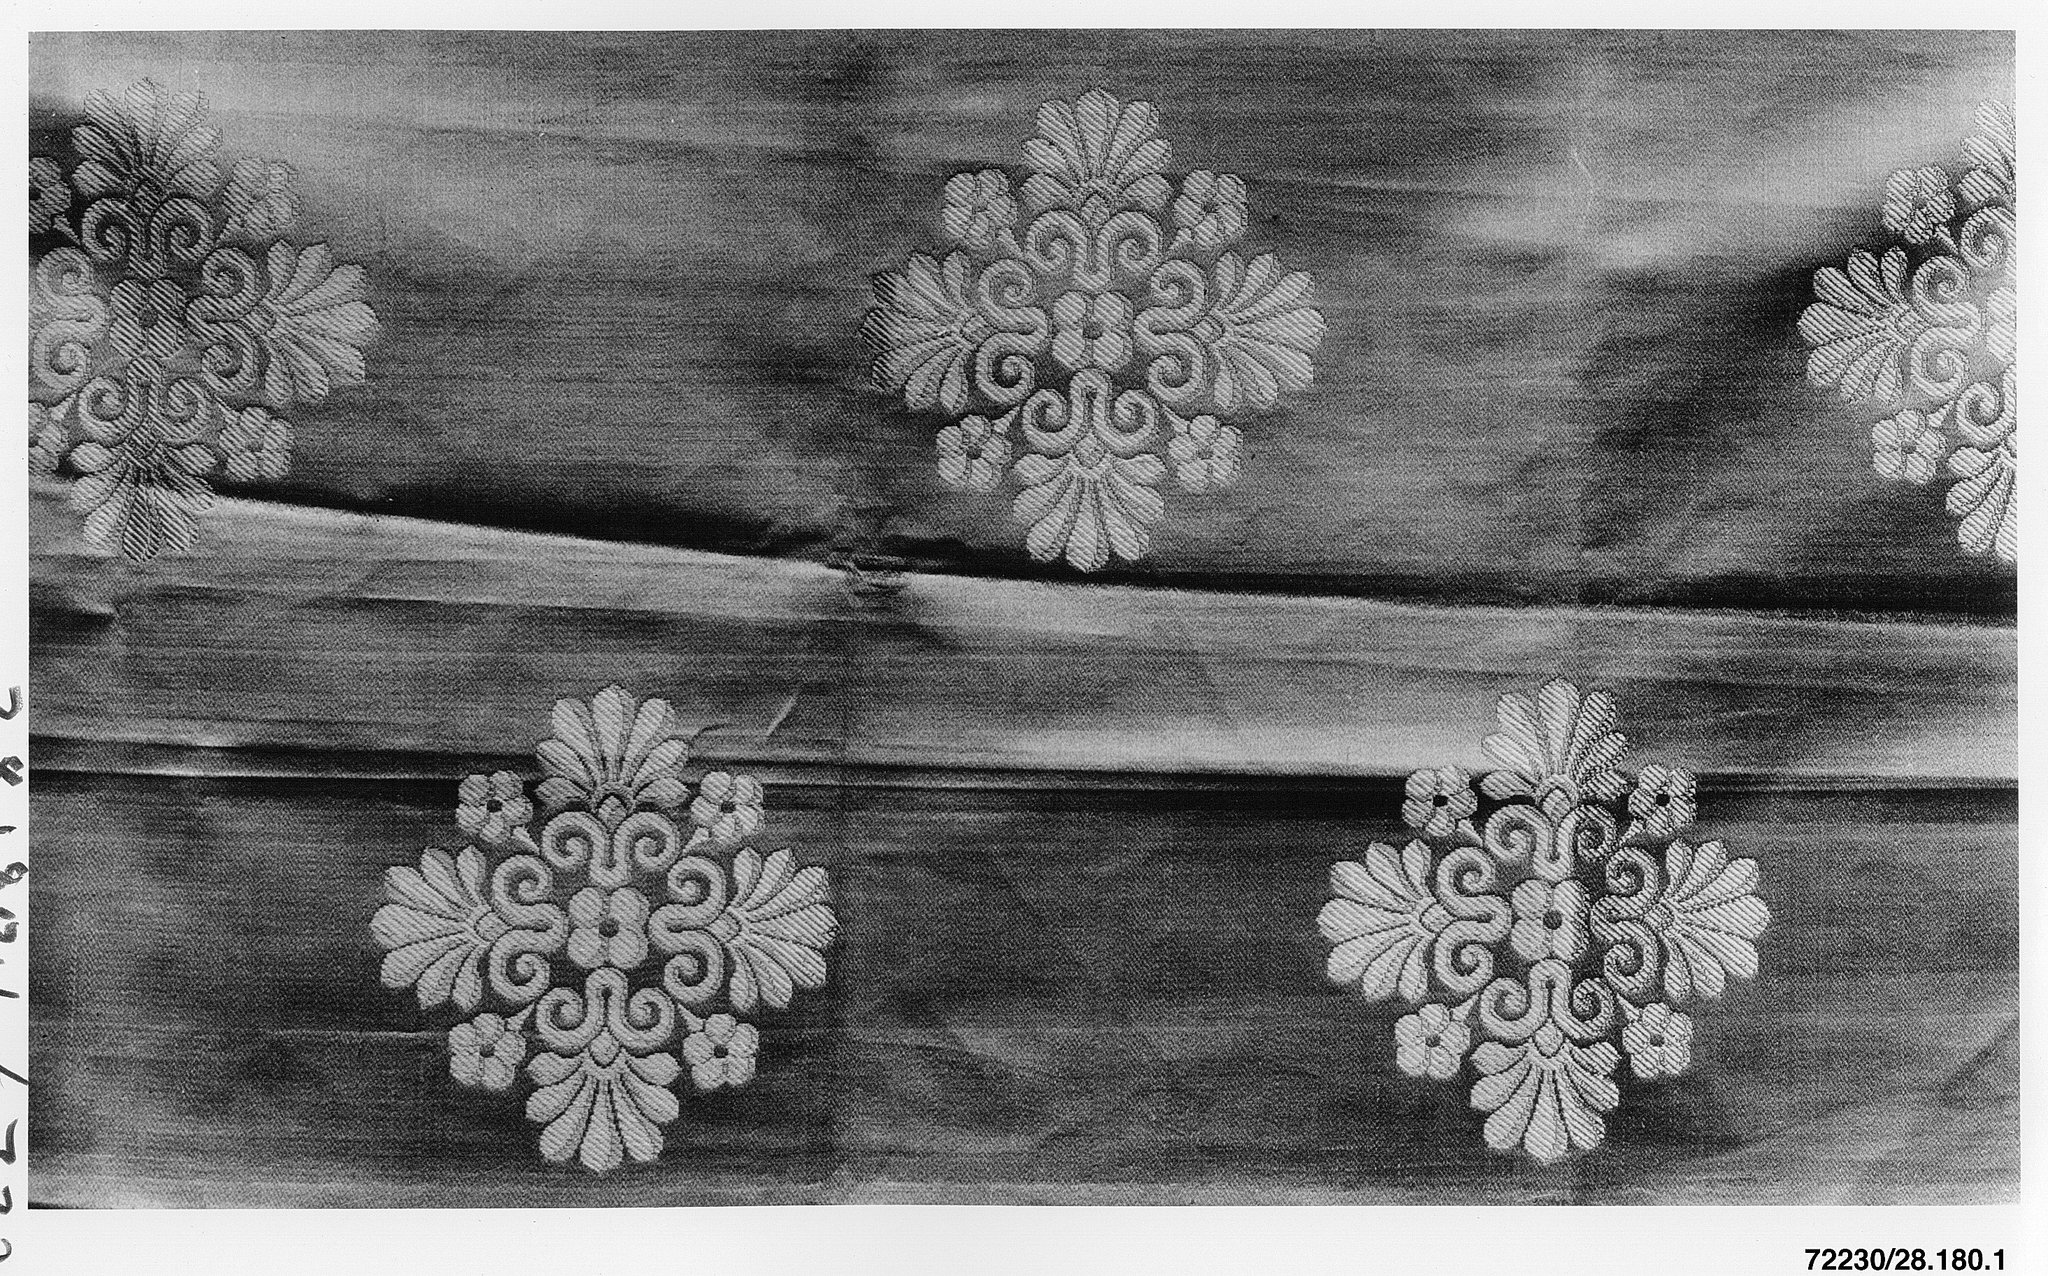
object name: piece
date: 1804-1815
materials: silk